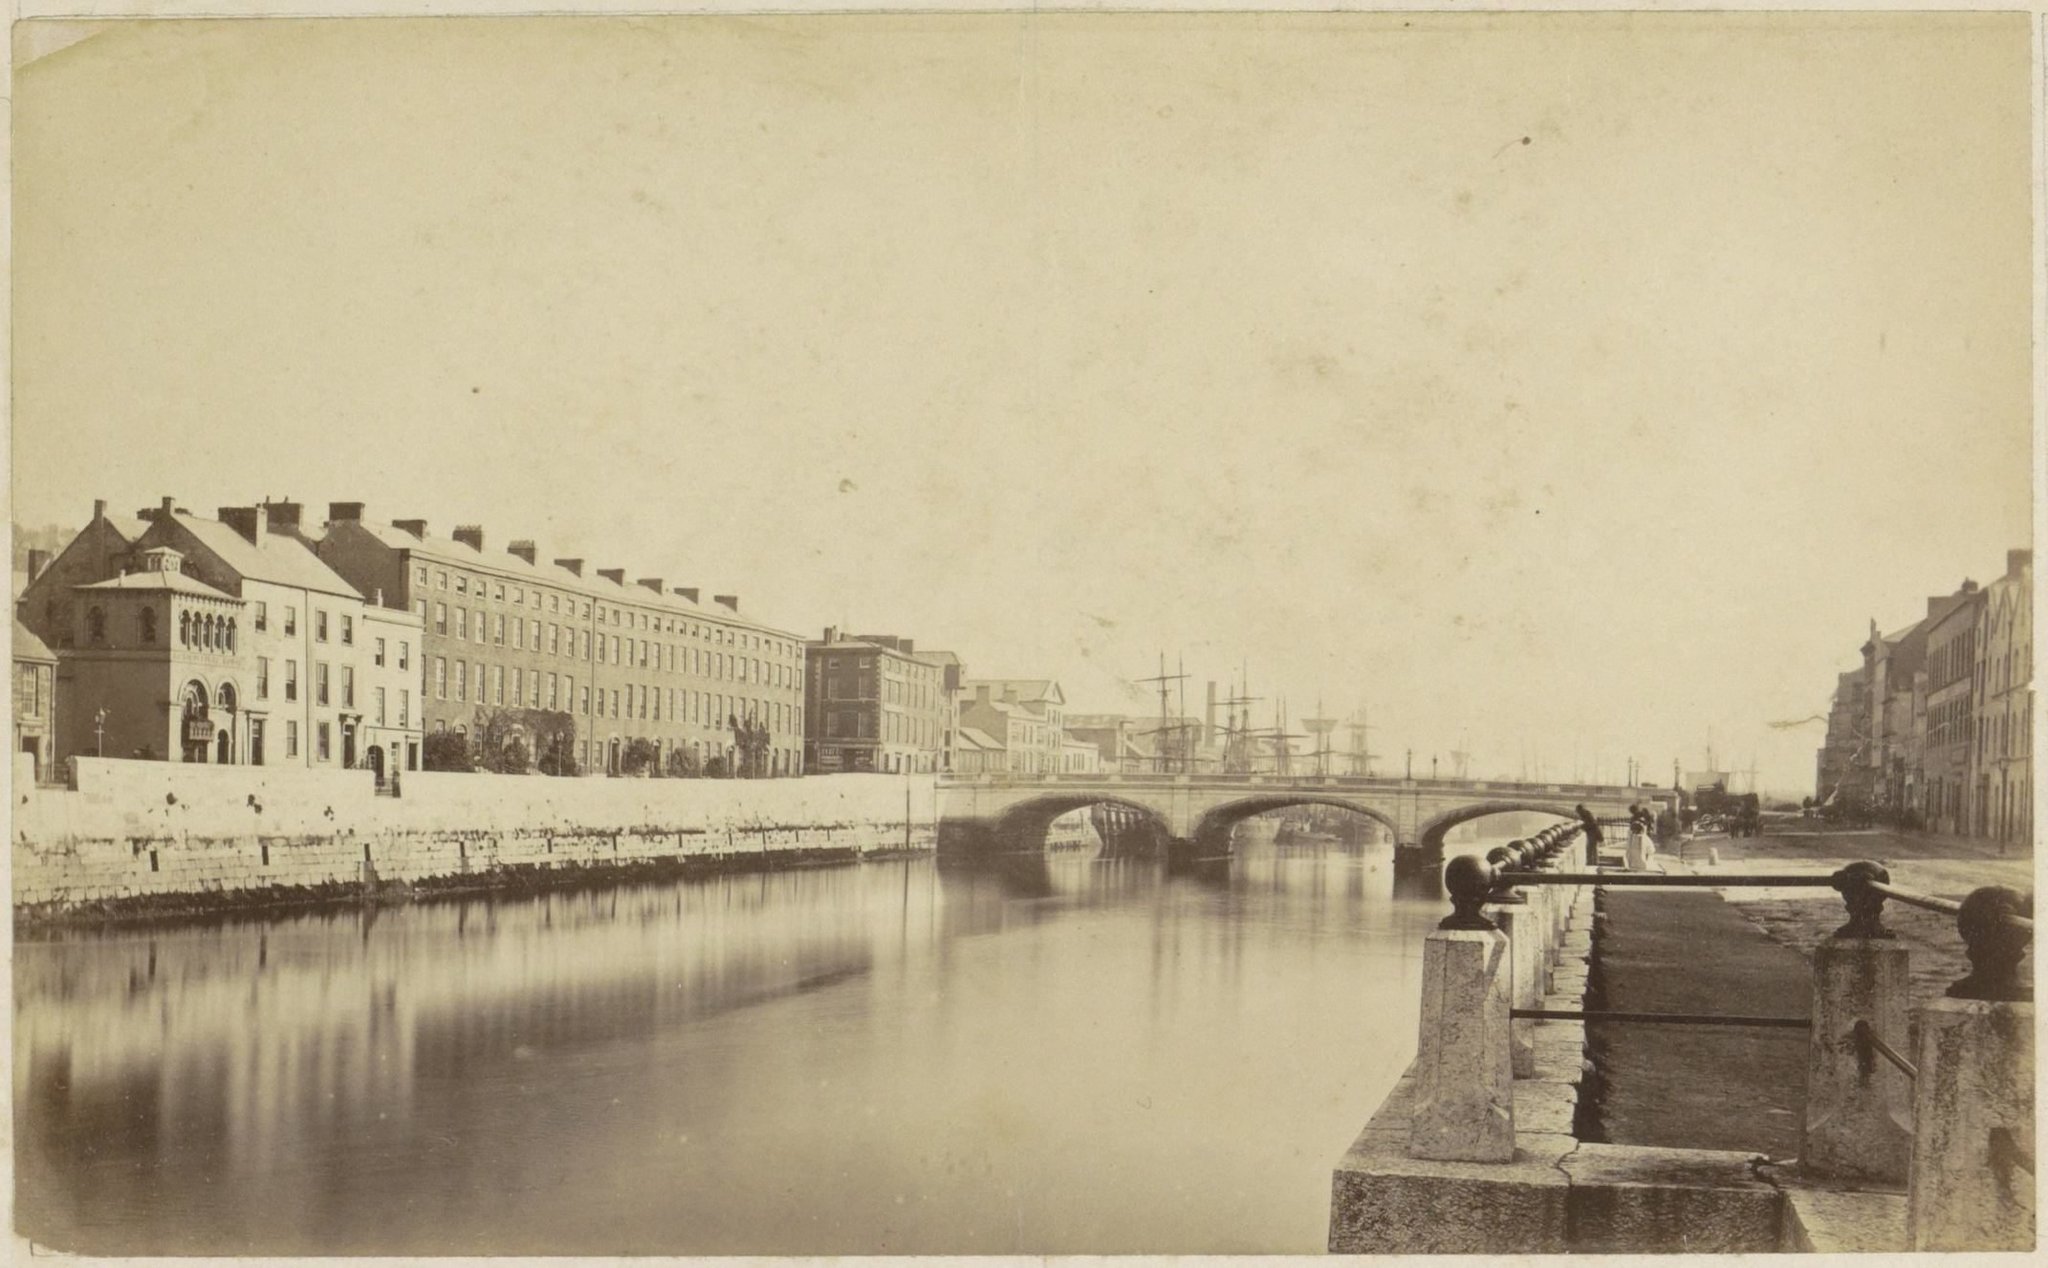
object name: photograph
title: Gezicht op de kades en gebouwen van een havenstad, vermoedelijk in Engeland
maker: Anonymous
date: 1850-1870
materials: paper, photographic support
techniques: albumen print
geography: england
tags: harbour (+ view ~ vehicle, ship, etc.), england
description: Onderdeel van Album met foto's van bezienswaardigheden en landschappen in Engeland en van kunst.